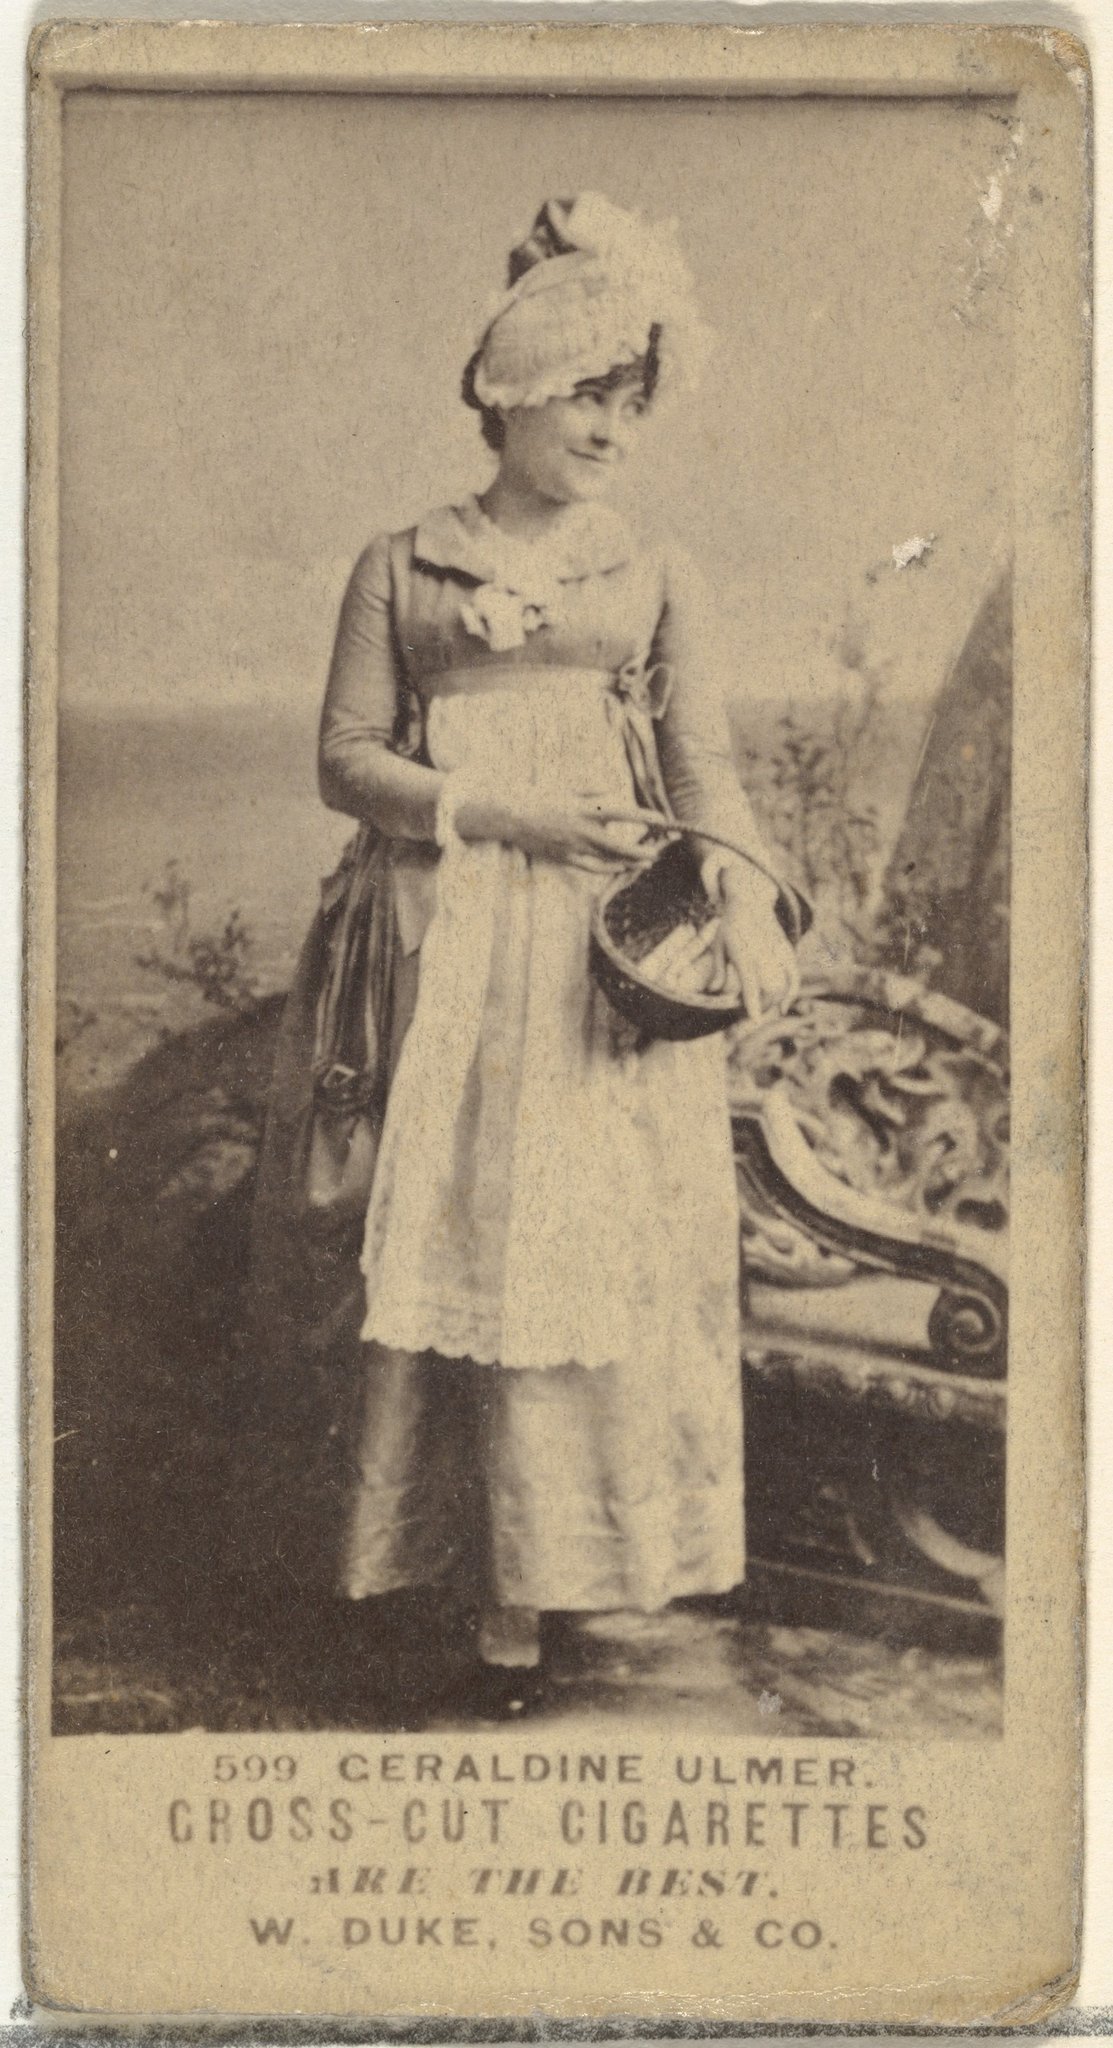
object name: photograph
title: Card Number 599, Geraldine Ulmer, from the Actors and Actresses series (N145-3) issued by Duke Sons & Co. to promote Cross Cut Cigarettes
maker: w. duke, sons & co.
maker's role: publisher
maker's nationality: american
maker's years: 1870-1920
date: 1880-1889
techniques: albumen silver print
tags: portraits,women,actresses